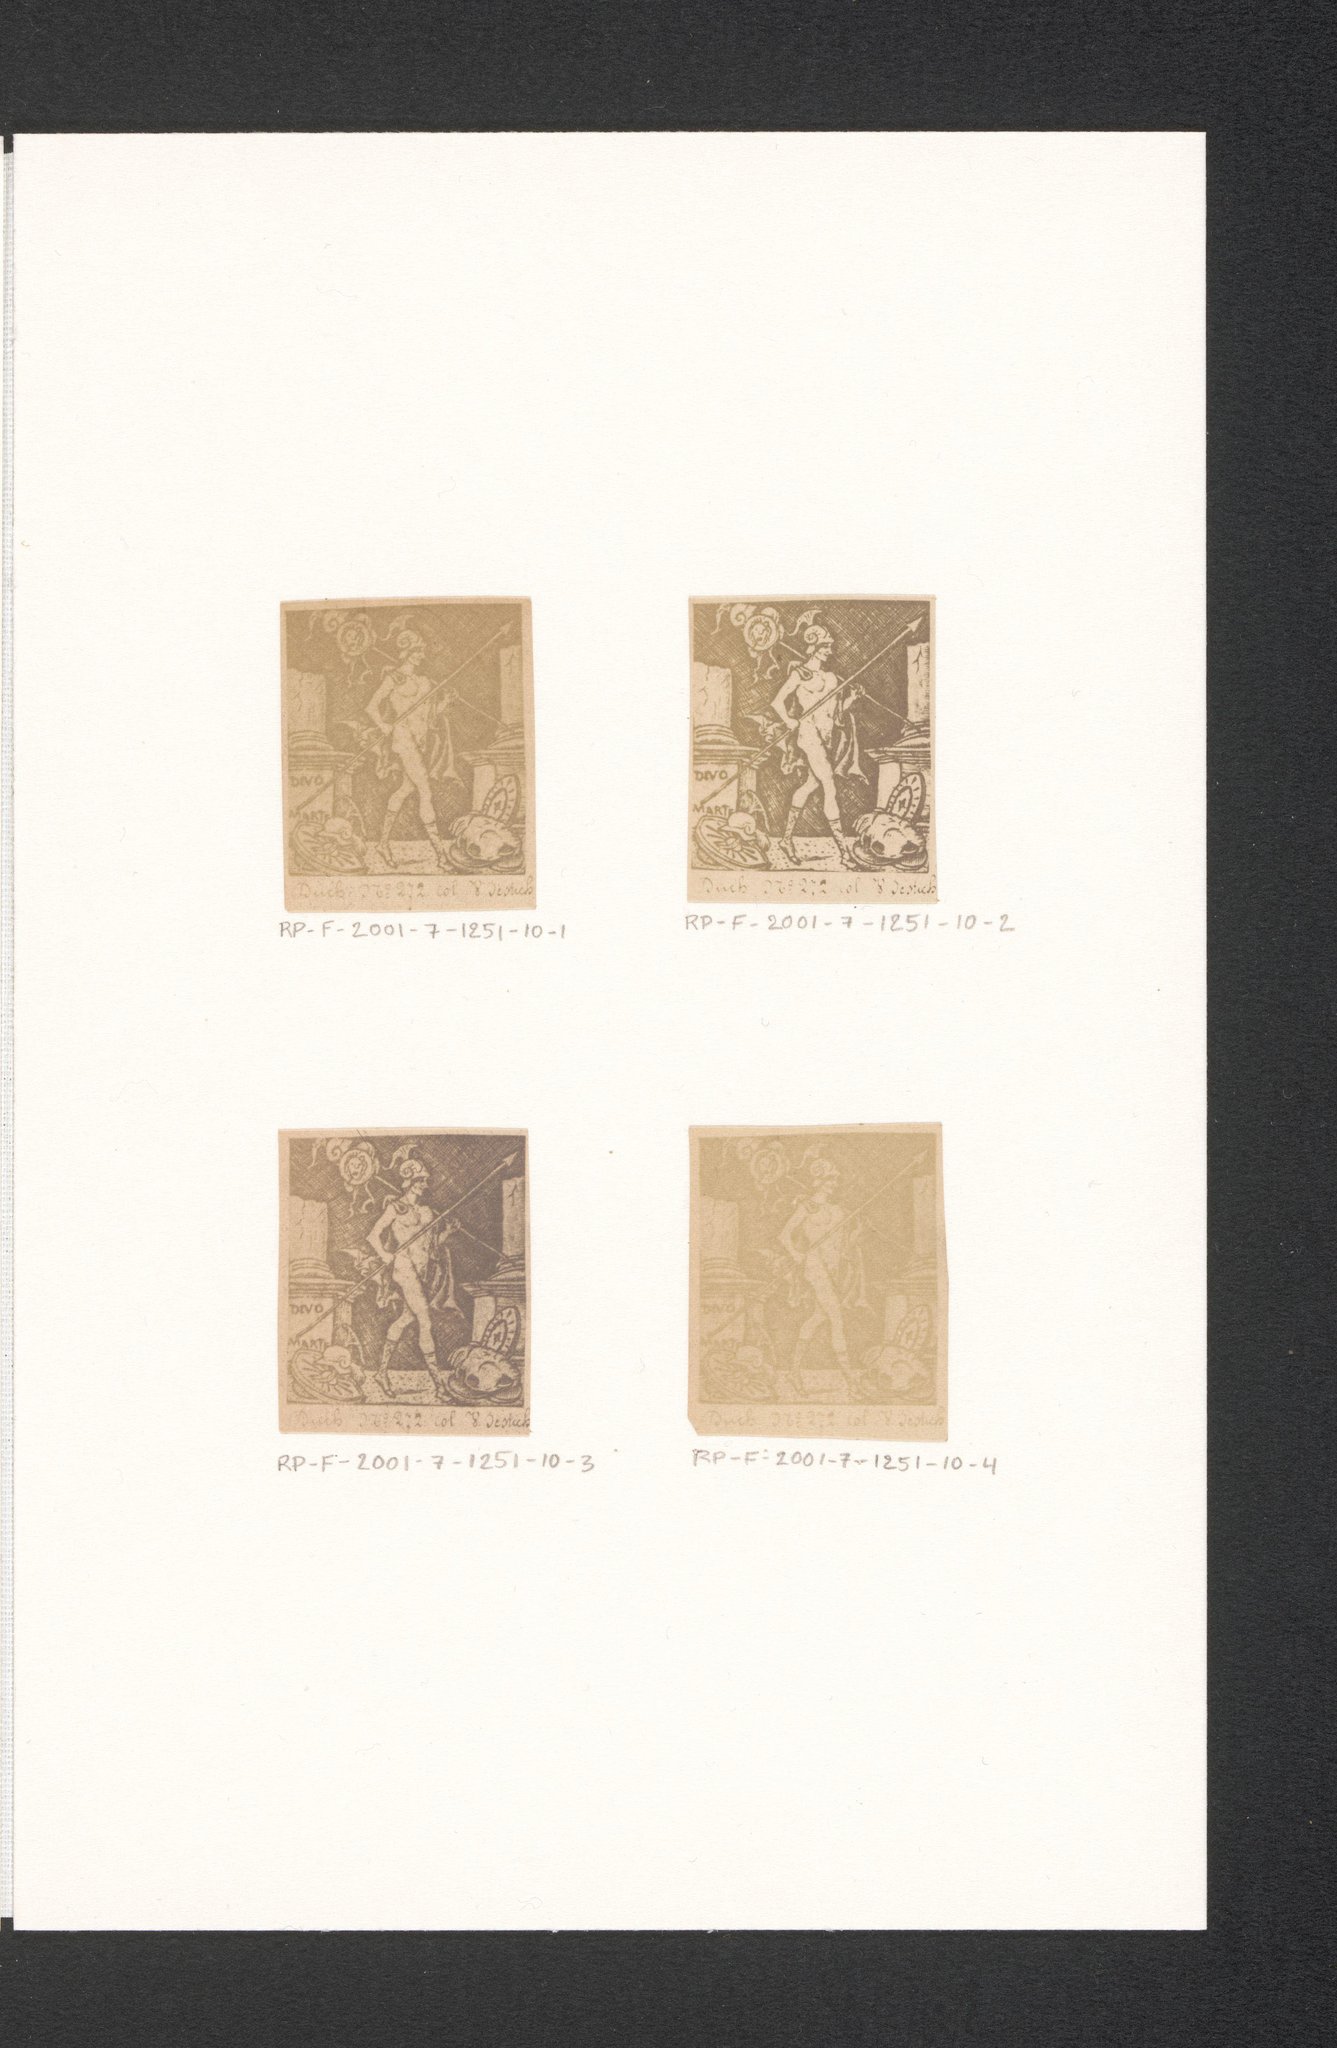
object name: page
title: Fotoreproductie van een prent van een krijger met een trofee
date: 1852-1857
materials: photographic support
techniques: salted paper print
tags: adult man, trophy ~ battle, war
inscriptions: inscription: ‘[Duch. No] 2[7]2. col. V. Sestich’